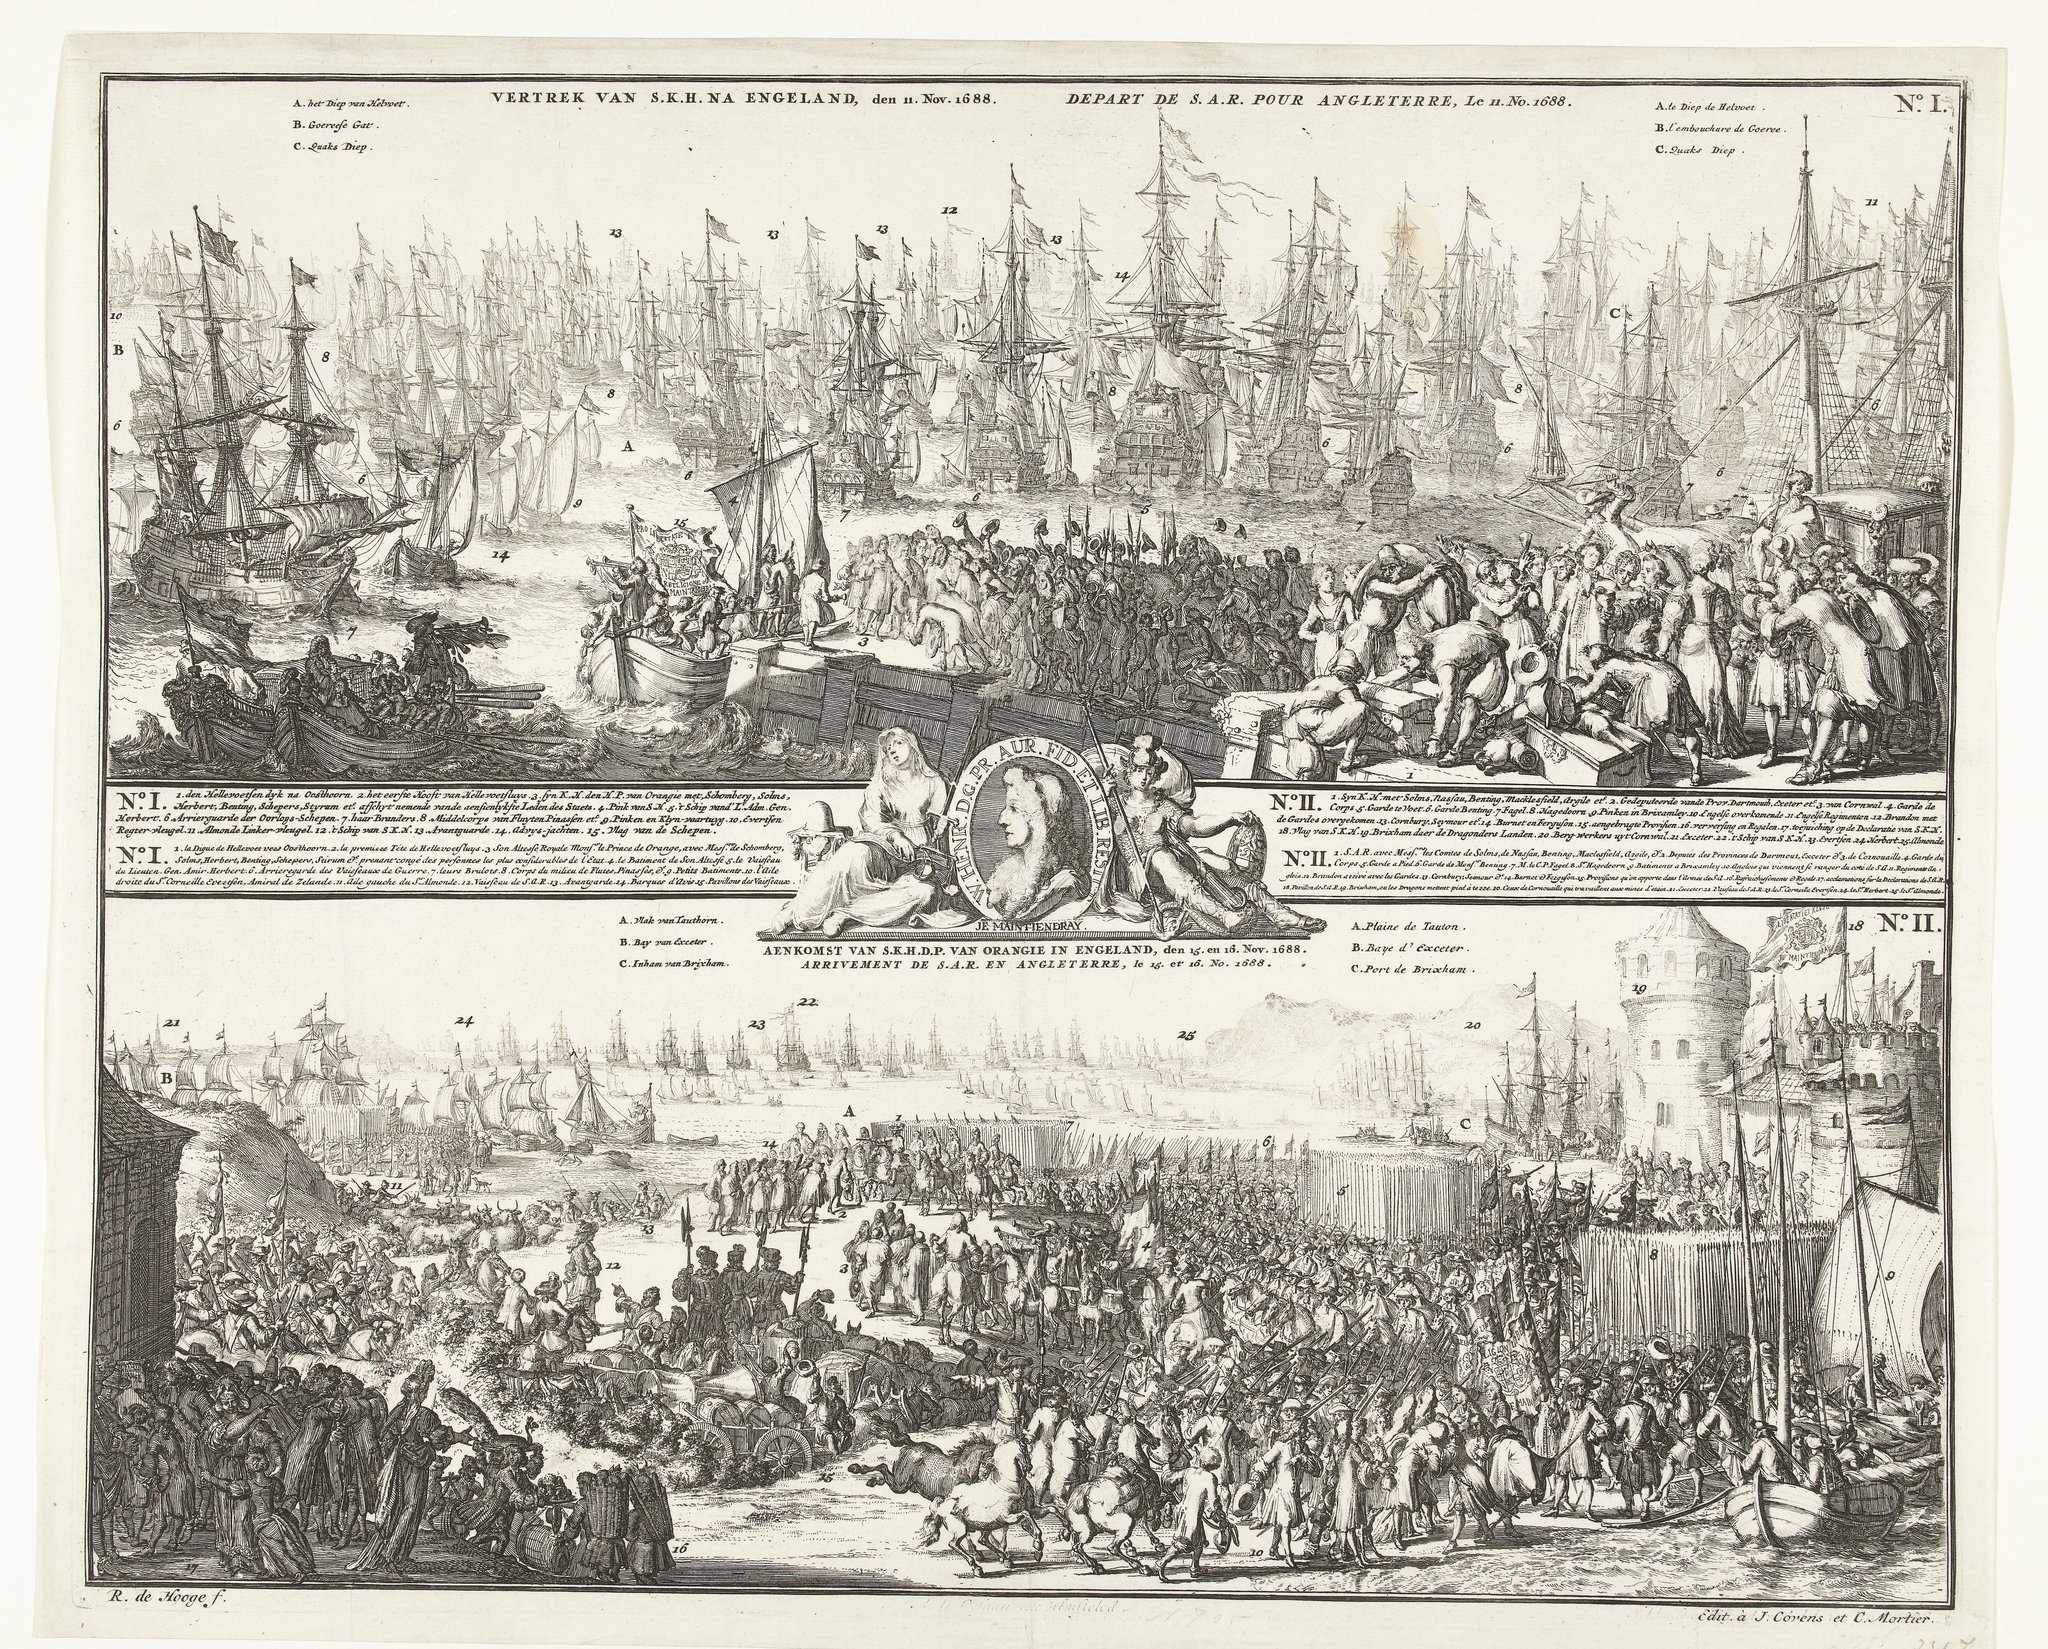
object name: print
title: Vertrek van S.K.H. na Engeland, den 11. Nov. 1688 / Aenkomst van S.K.H.D.P. van Orangie in Engeland, den 15. en 16. Nov. 1688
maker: romeyn de hooghe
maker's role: draughtsman, goldsmith, painter, print maker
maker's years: 1645-1708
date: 1688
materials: paper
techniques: etching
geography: northern netherlands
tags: the hague, william iii (prince of orange and king of england, scotland, and ireland), arrival and return ~ travelling, departure ~ travelling, hellevoetsluis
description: Tocht van Willem III naar Engeland, 1688. Twee voorstellingen, genummerd I en II. Boven: het vertek van Willem met zijn vloot op 11 november 1688 vanuit Hellevoetsluis. Volle kade en overzicht van de schepen. Onder de voorstelling een verklaring van de cijfers 1-15 in het Nederlands en Frans. Onder de aankomst van de vloot van de prins in Torbay bij Brixham, 15 en 16 november 1688. Op de voorgrond gaat de prins aan land. Boven de voorstelling een verklaring van de cijfers 1-15 in het Nederlands en Frans. In het midden een portret van de prins in profiel naar links met Rechtvaardigheid en Nederlandse Maagd.